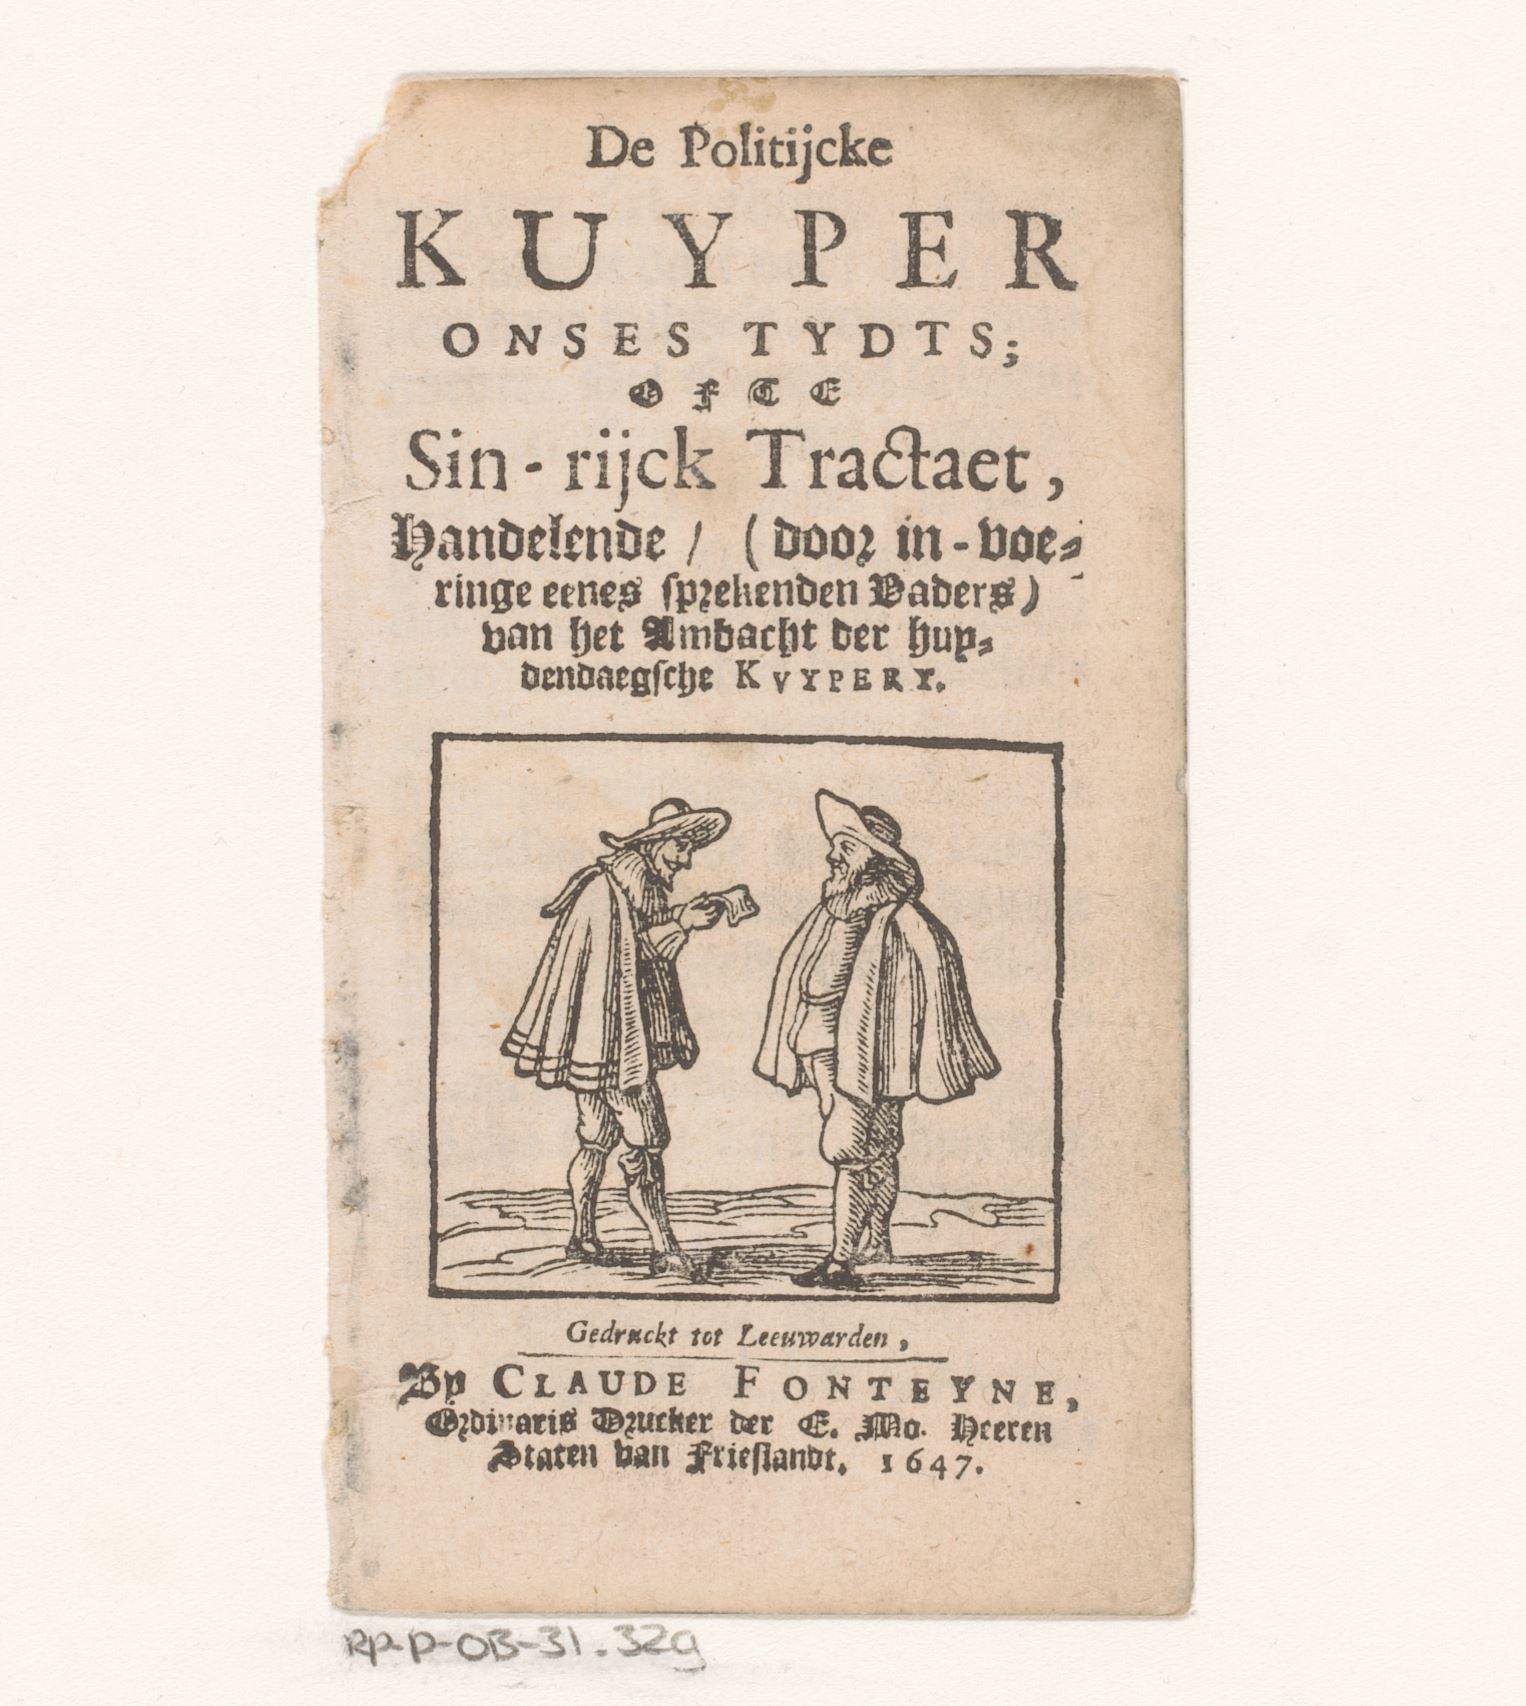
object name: print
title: Titelpagina voor: Bernhard Alting, De politĳcke kuyper onses tydts, 1647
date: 1647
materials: paper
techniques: letterpress printing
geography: leeuwarden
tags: adult man (+ two persons), reading to somebody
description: Titelpagina voor: Alting, Bernhard. De politĳcke kuyper onses tydts. Leeuwarden: Claude Fonteyne, 1647.